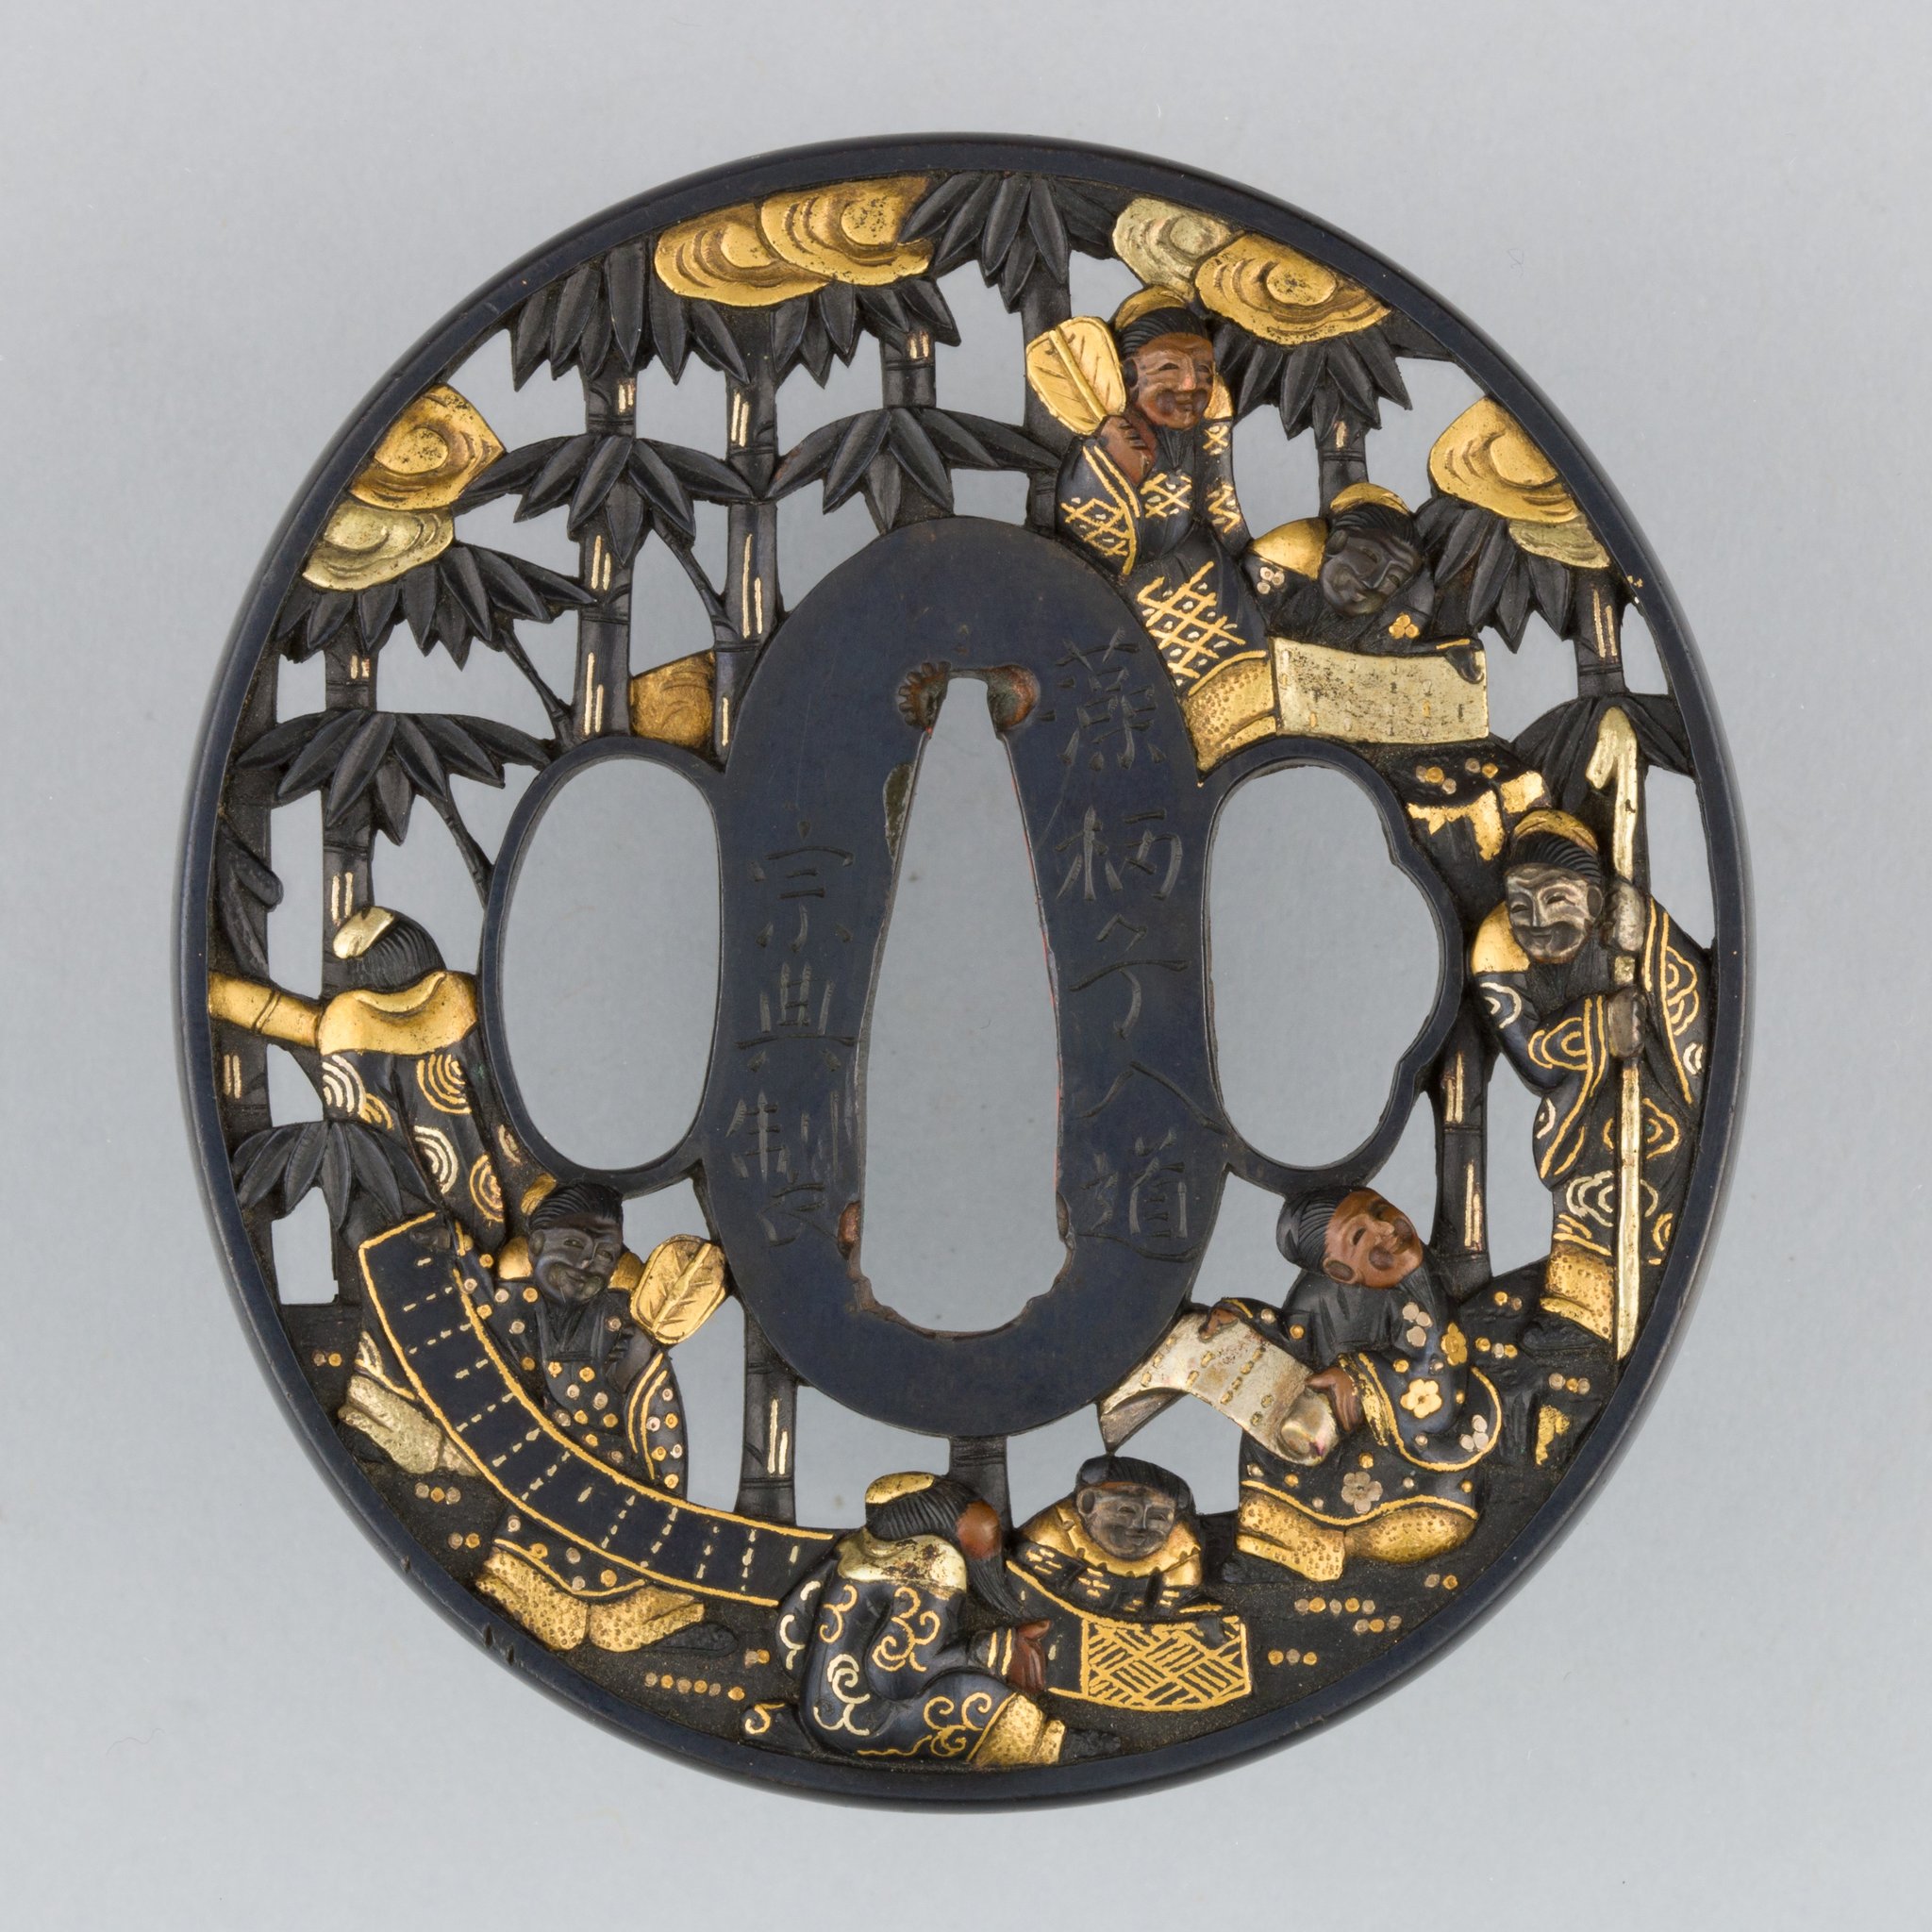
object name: sword guard tsuba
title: Sword Guard (Tsuba)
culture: japanese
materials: copper, gold alloy, gold, silver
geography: japan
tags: men